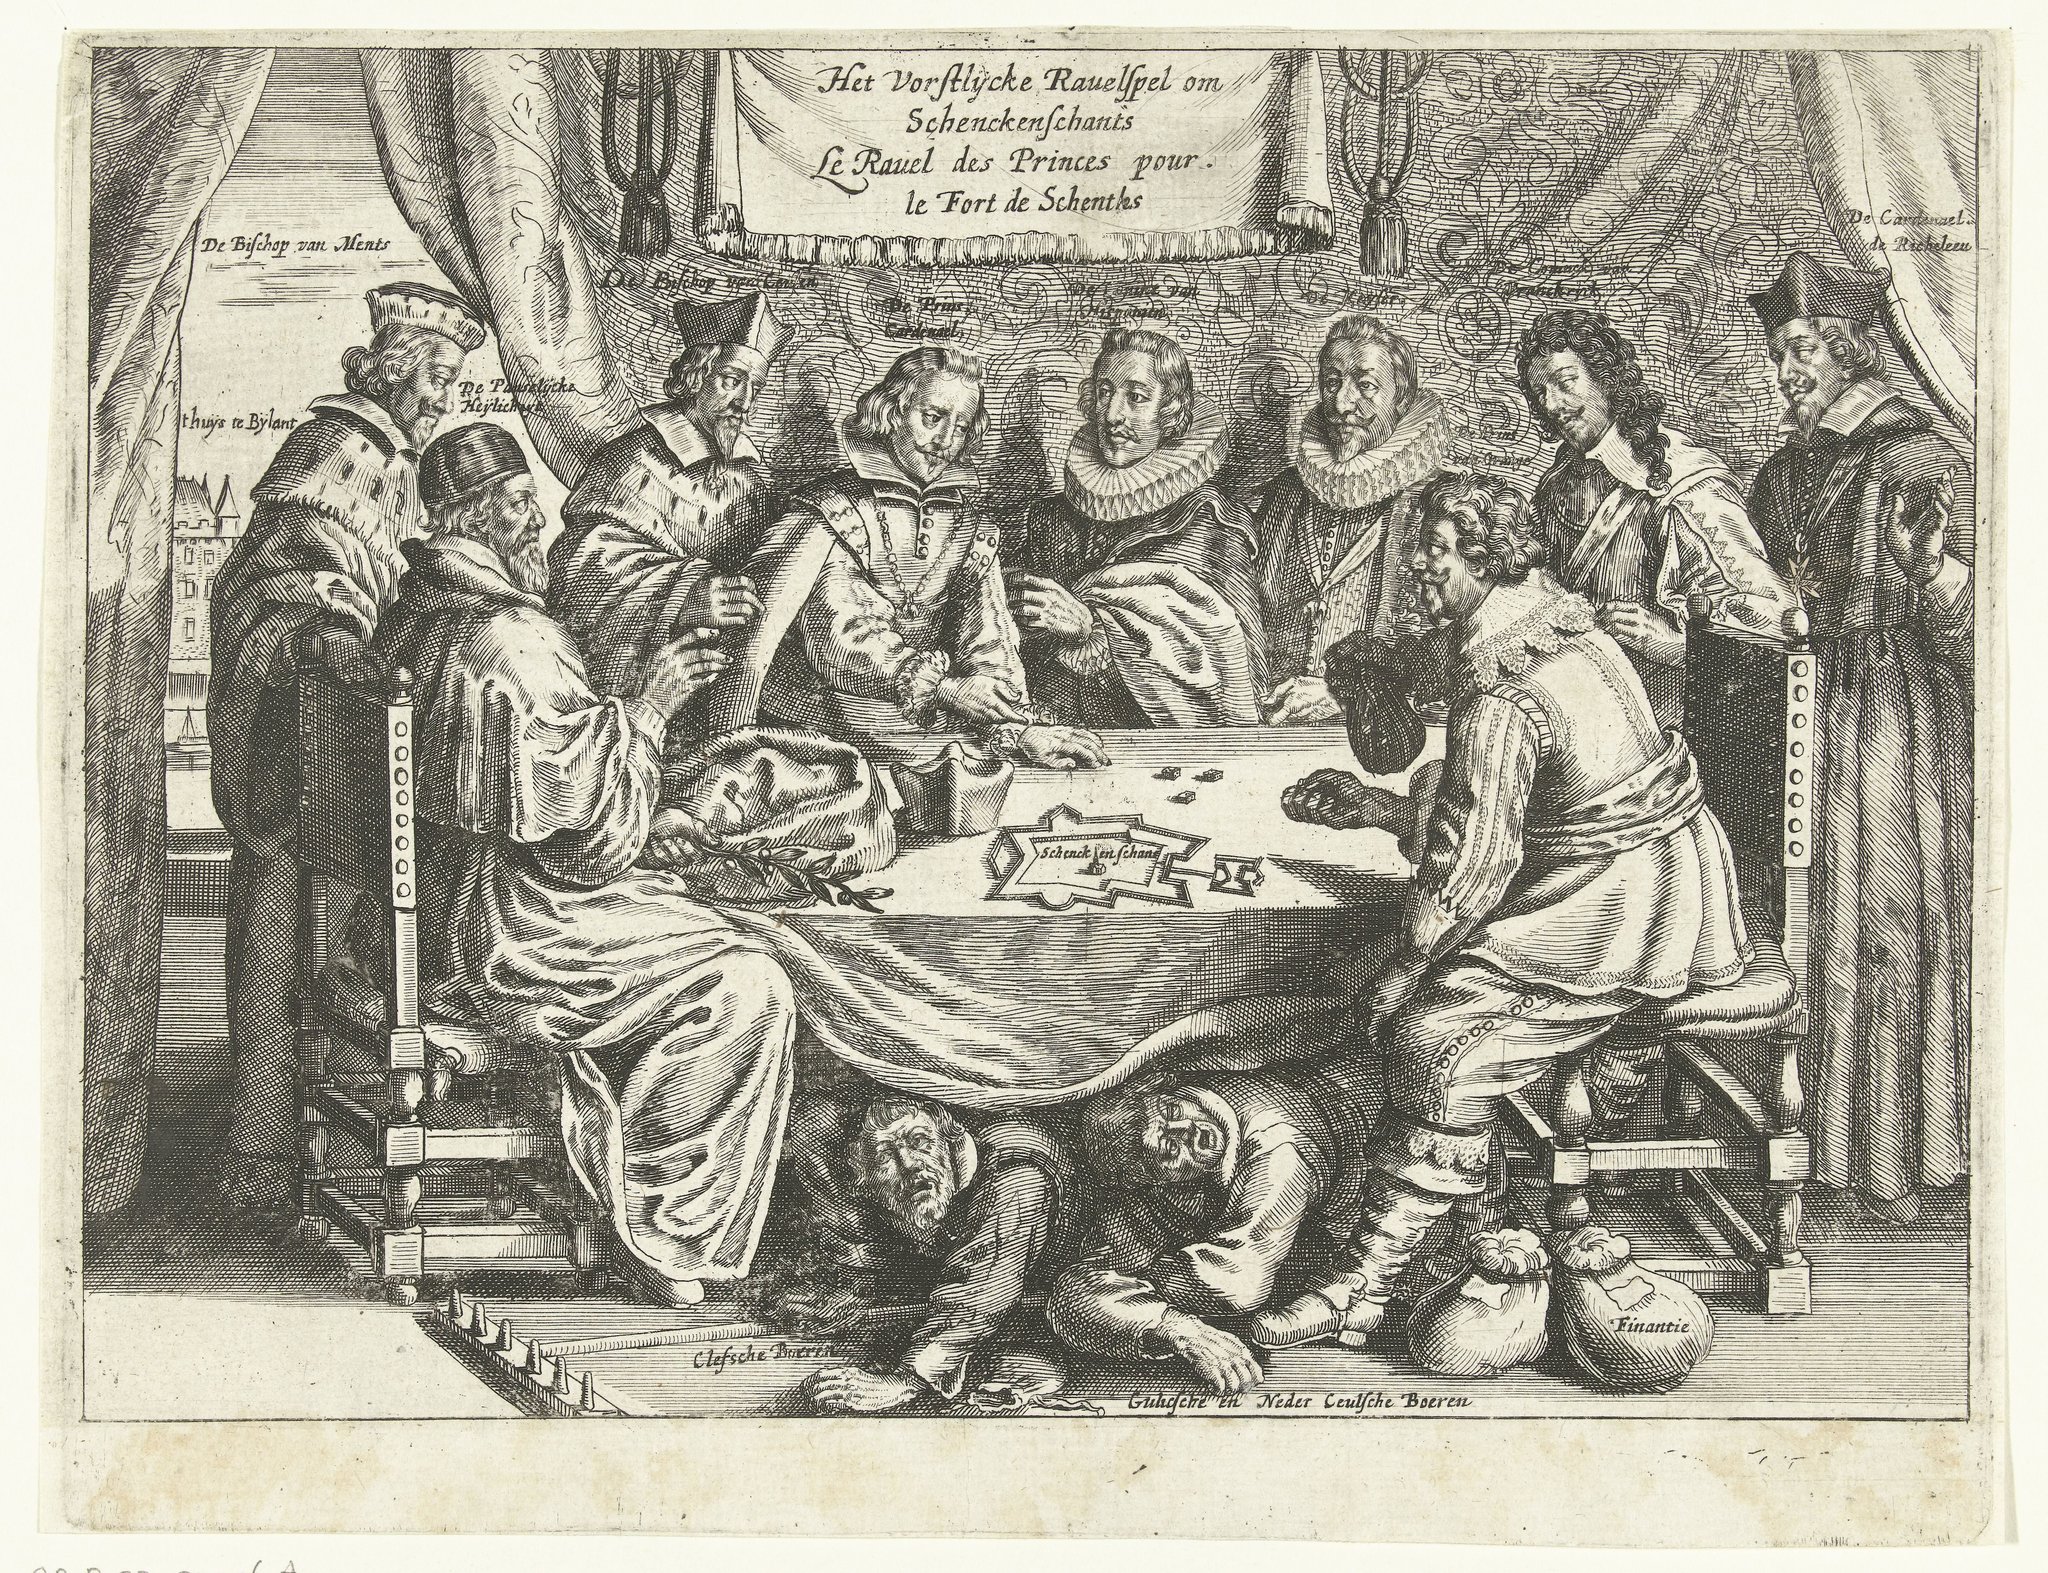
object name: print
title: Het Vorstelijcke Ravelspel om Schenckenschants / Le Ravel des Princes pour le Fort de Schentks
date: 1635-1636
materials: paper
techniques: engraving, etching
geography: low countries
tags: frederick henry (prince of orange), filips iv (koning van spanje), vienna, ferdinand ii (duits keizer), rome, clergyman, urbanus viii, ferdinand van beieren, armand-jean du plessis hertog van richelieu, brussels, landvoogd der zuidelijke nederlanden ferdinand van oostenrijk, lodewijk xiii (koning van frankrijk), dice-games, political caricatures and satires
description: Spotprent op de strijd om Schenckenschans in de jaren 1635-1636. Frederik Hendrik en de kardinaal infant Ferdinand dobbelen aan een tafel om het fort. Hierbij ook aanwezig zijn de paus, de bisschoppen van Mainz en Keulen, de koning van Spanje, de keizer, de koning van Frankrijk en kardinaal Richelieu. Slachtoffers van het spel zijn de Kleefse en Gulikse boeren die kermend onder de tafel liggen. Bij de prent behoort een los tekstblad.